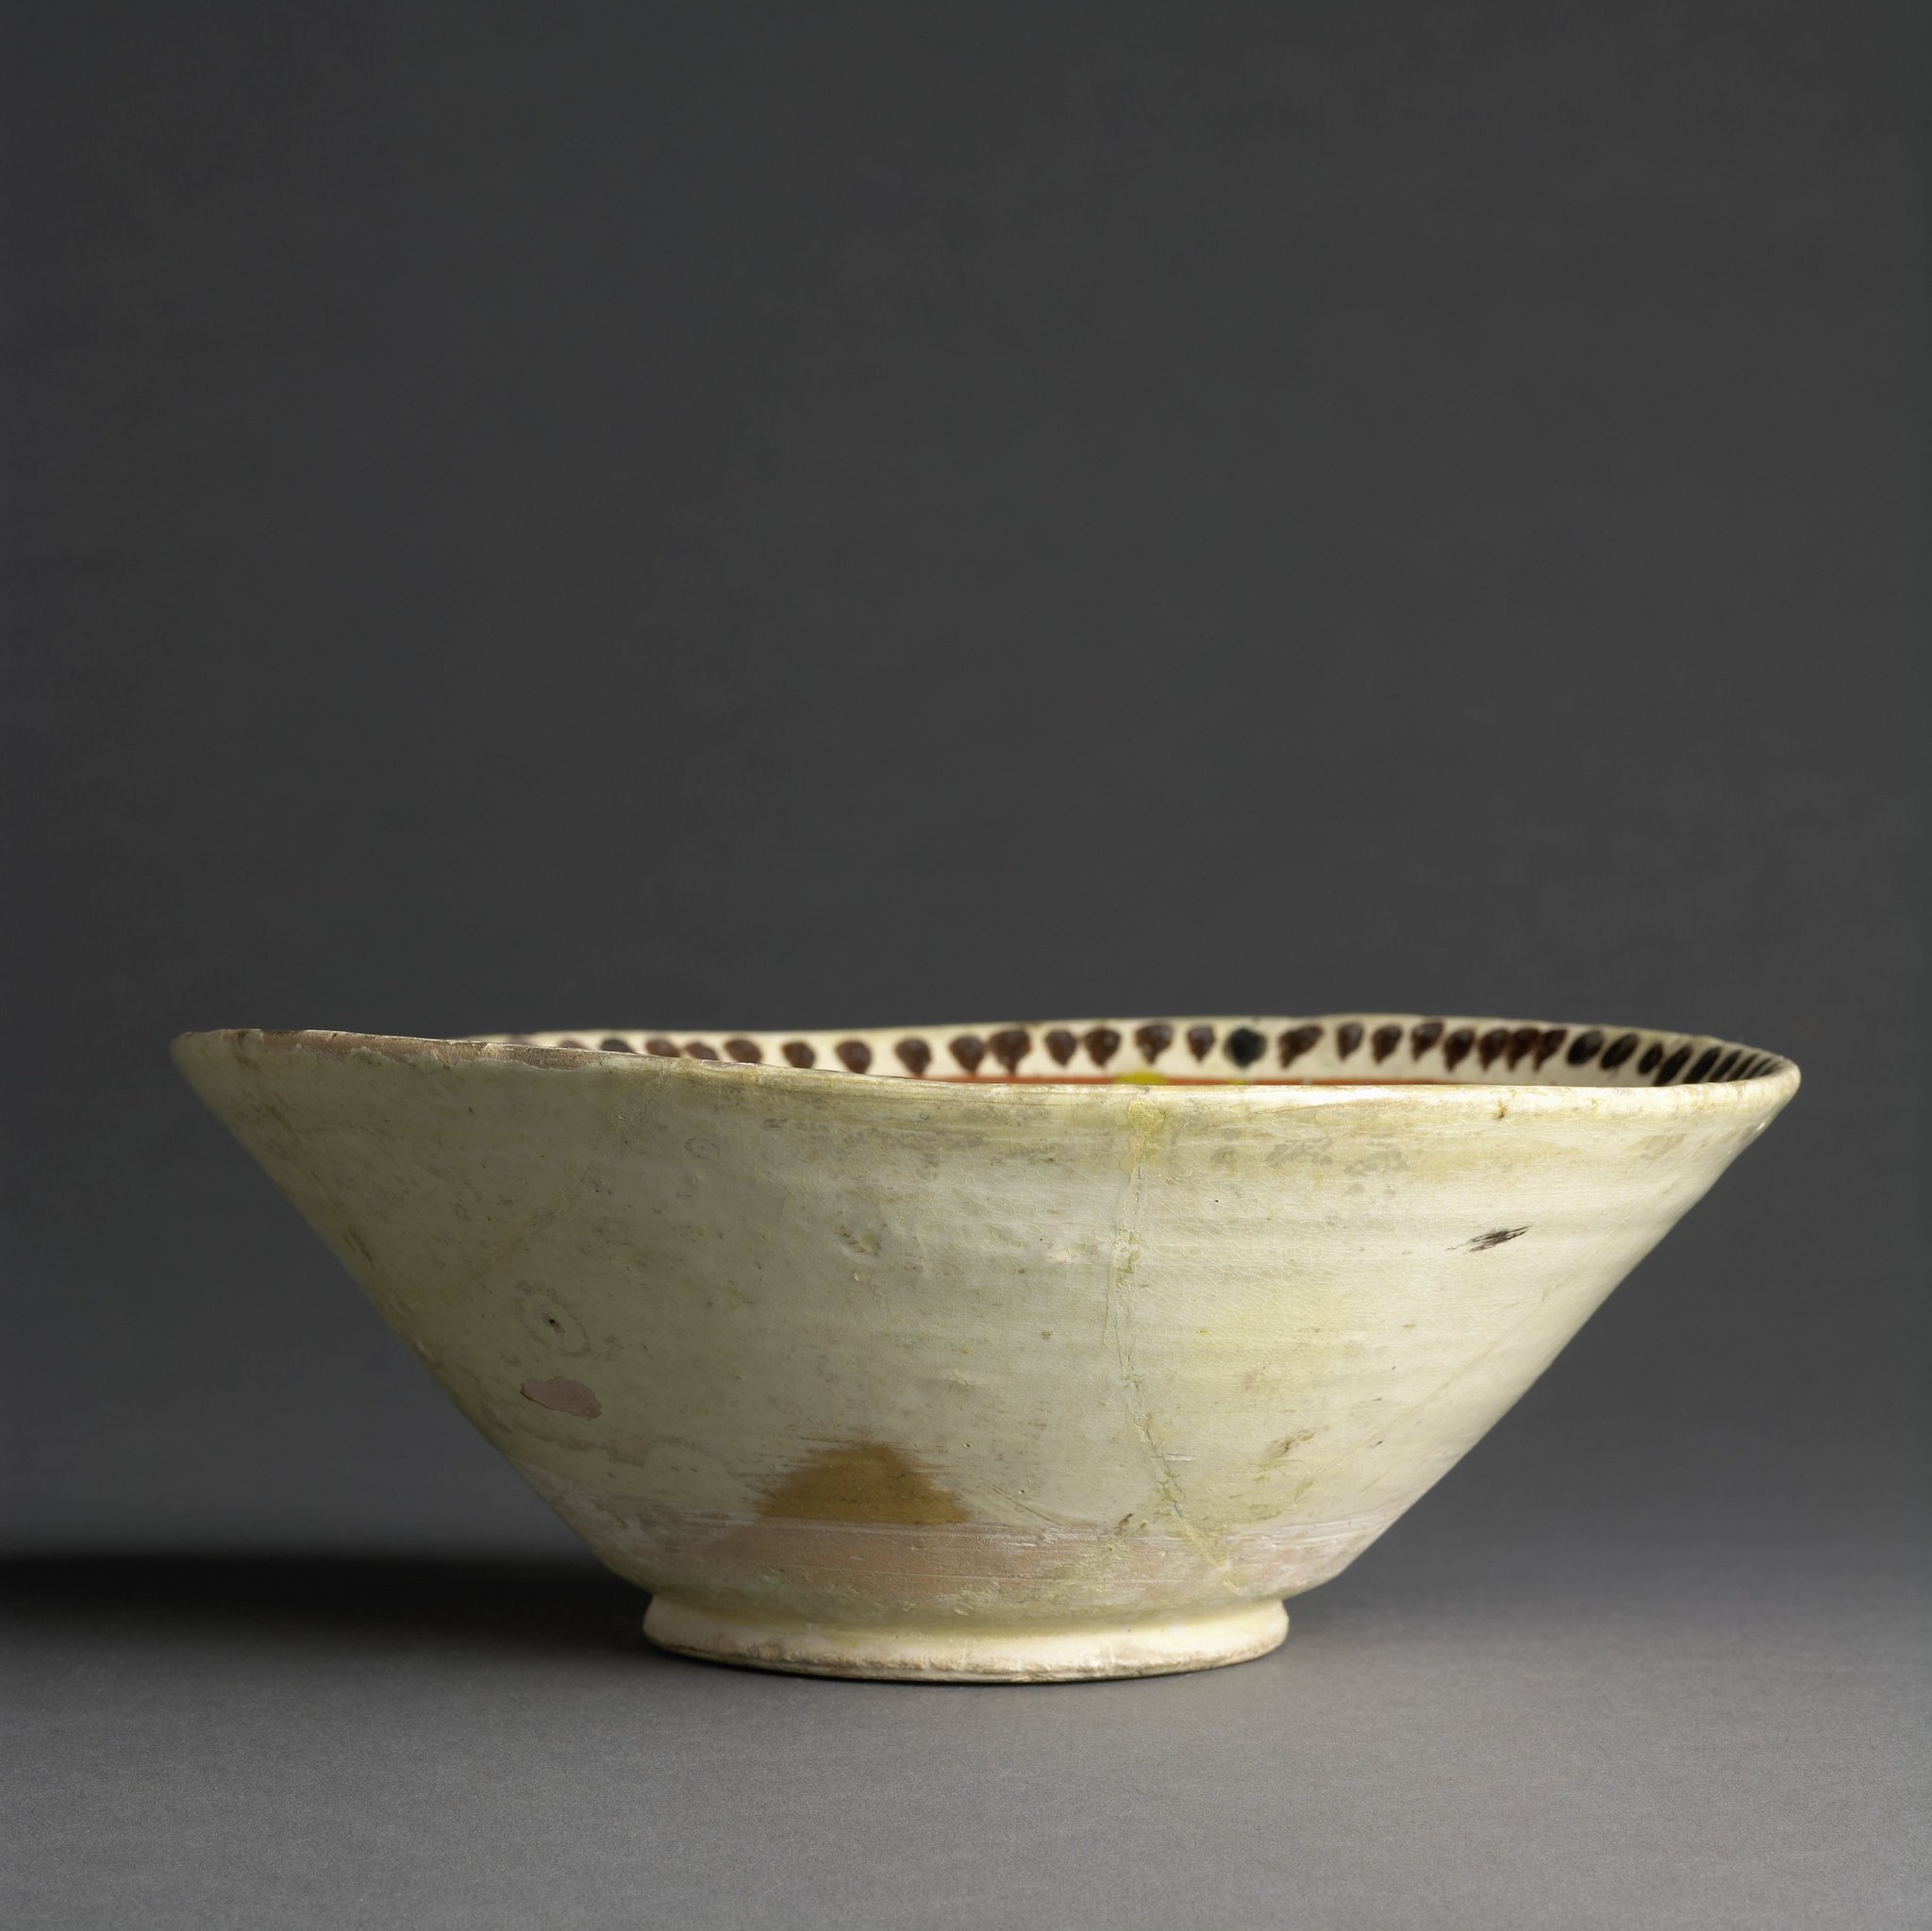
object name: bowl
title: Bowl with an inscription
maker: Anonymous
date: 900-999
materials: earthenware, glaze, paint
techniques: firing, turning, vitrification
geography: nishapur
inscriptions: : ‘'Allah' of 'al yoemn' (herhaald)’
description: In the Islamic world calligraphy is considered the highest form of art. After all, the Koran is transmitted through writing. Some objects are decorated with pseudo writing devoid of meaning and serving a purely symbolic or aesthetic function. The inscriptions on this early 10th-century Iranian piece of pottery are still in Arabic. The repetitive pattern painted on this bowl may be the word Allah or al yumn, which means ‘prosperity’.